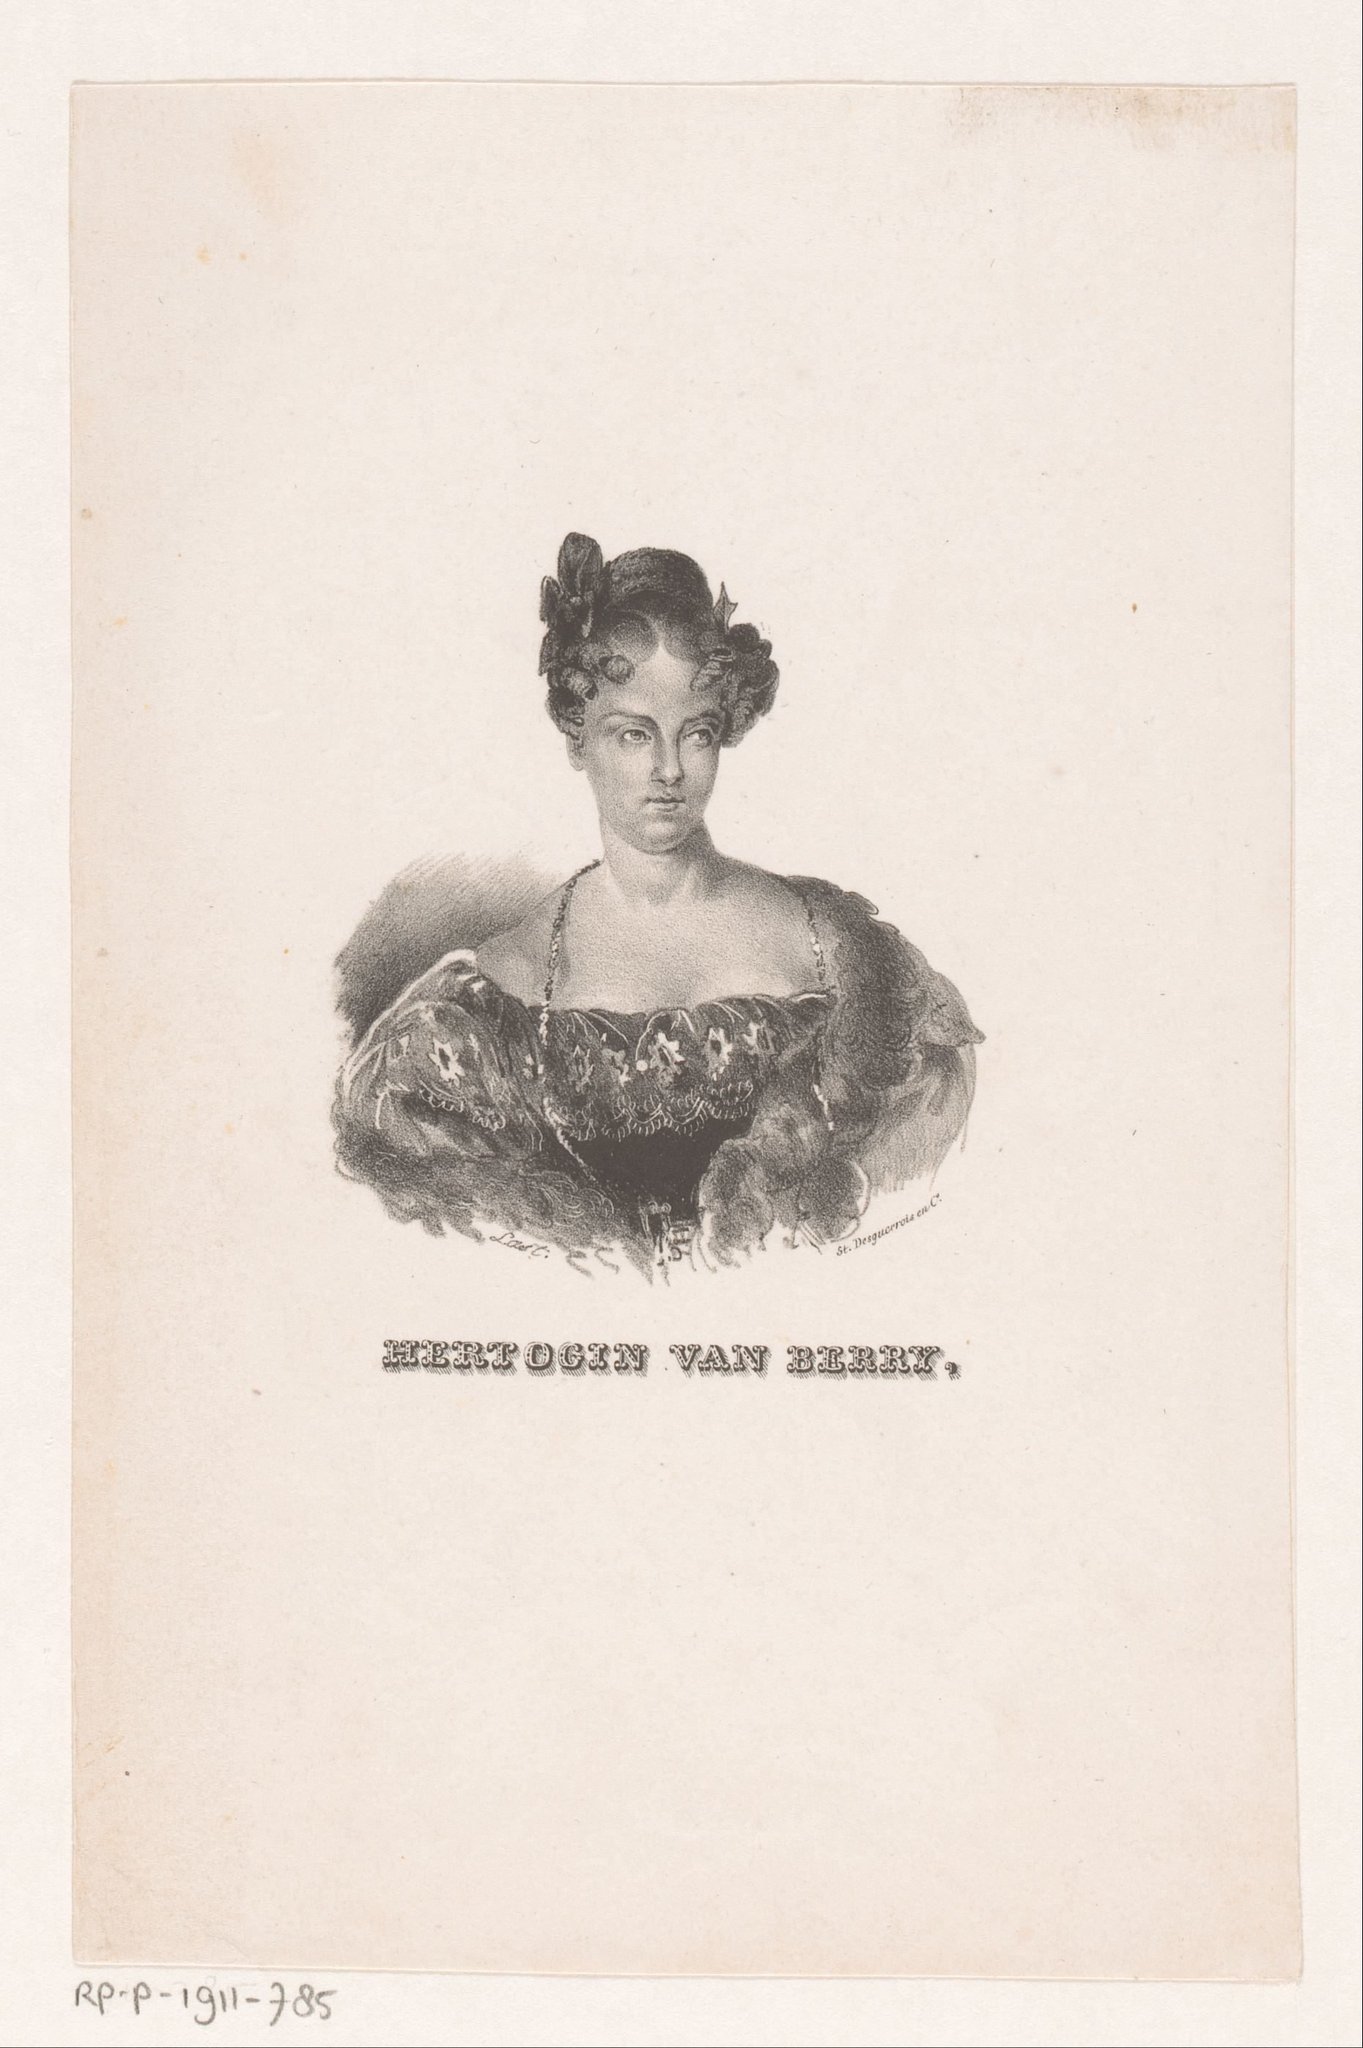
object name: print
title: Portret van Maria Carolina van Bourbon-Sicilië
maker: carel christiaan antony last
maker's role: print maker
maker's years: 1808-1876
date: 1818-1876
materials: paper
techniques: lithograph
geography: netherlands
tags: historical persons - bb - woman (+ (full) bust portrait)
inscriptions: collector's mark: Lugt 2228